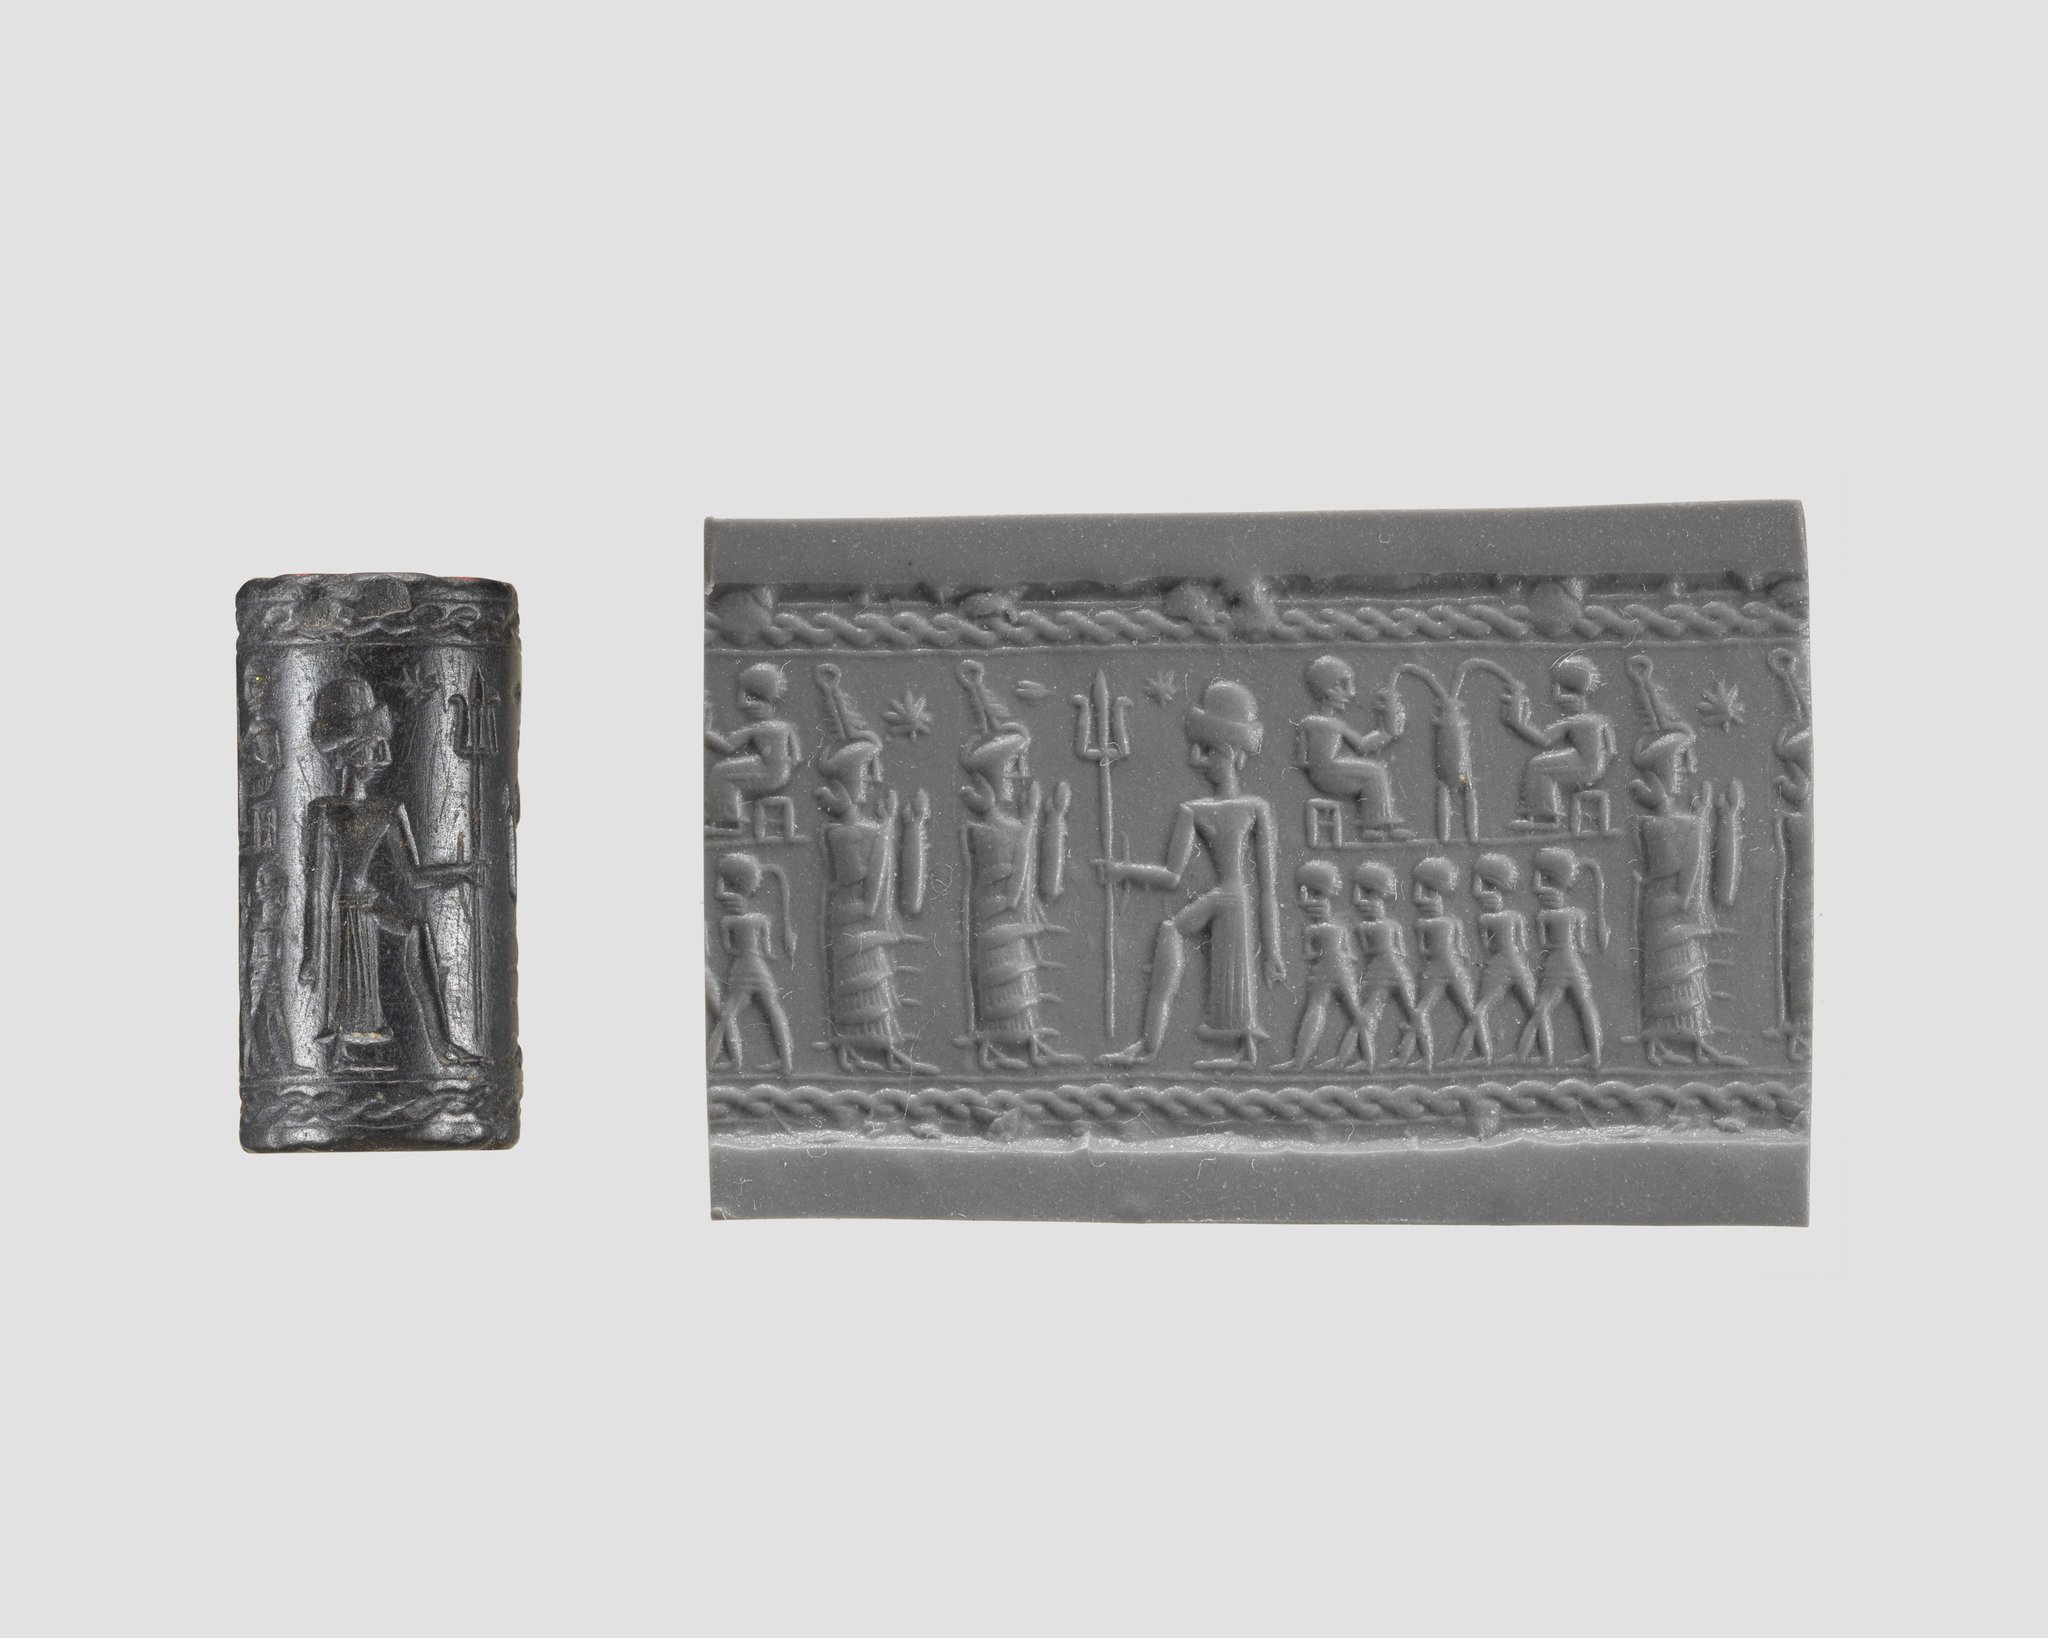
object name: cylinder seal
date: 1820-1730 BCE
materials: mineral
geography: syria